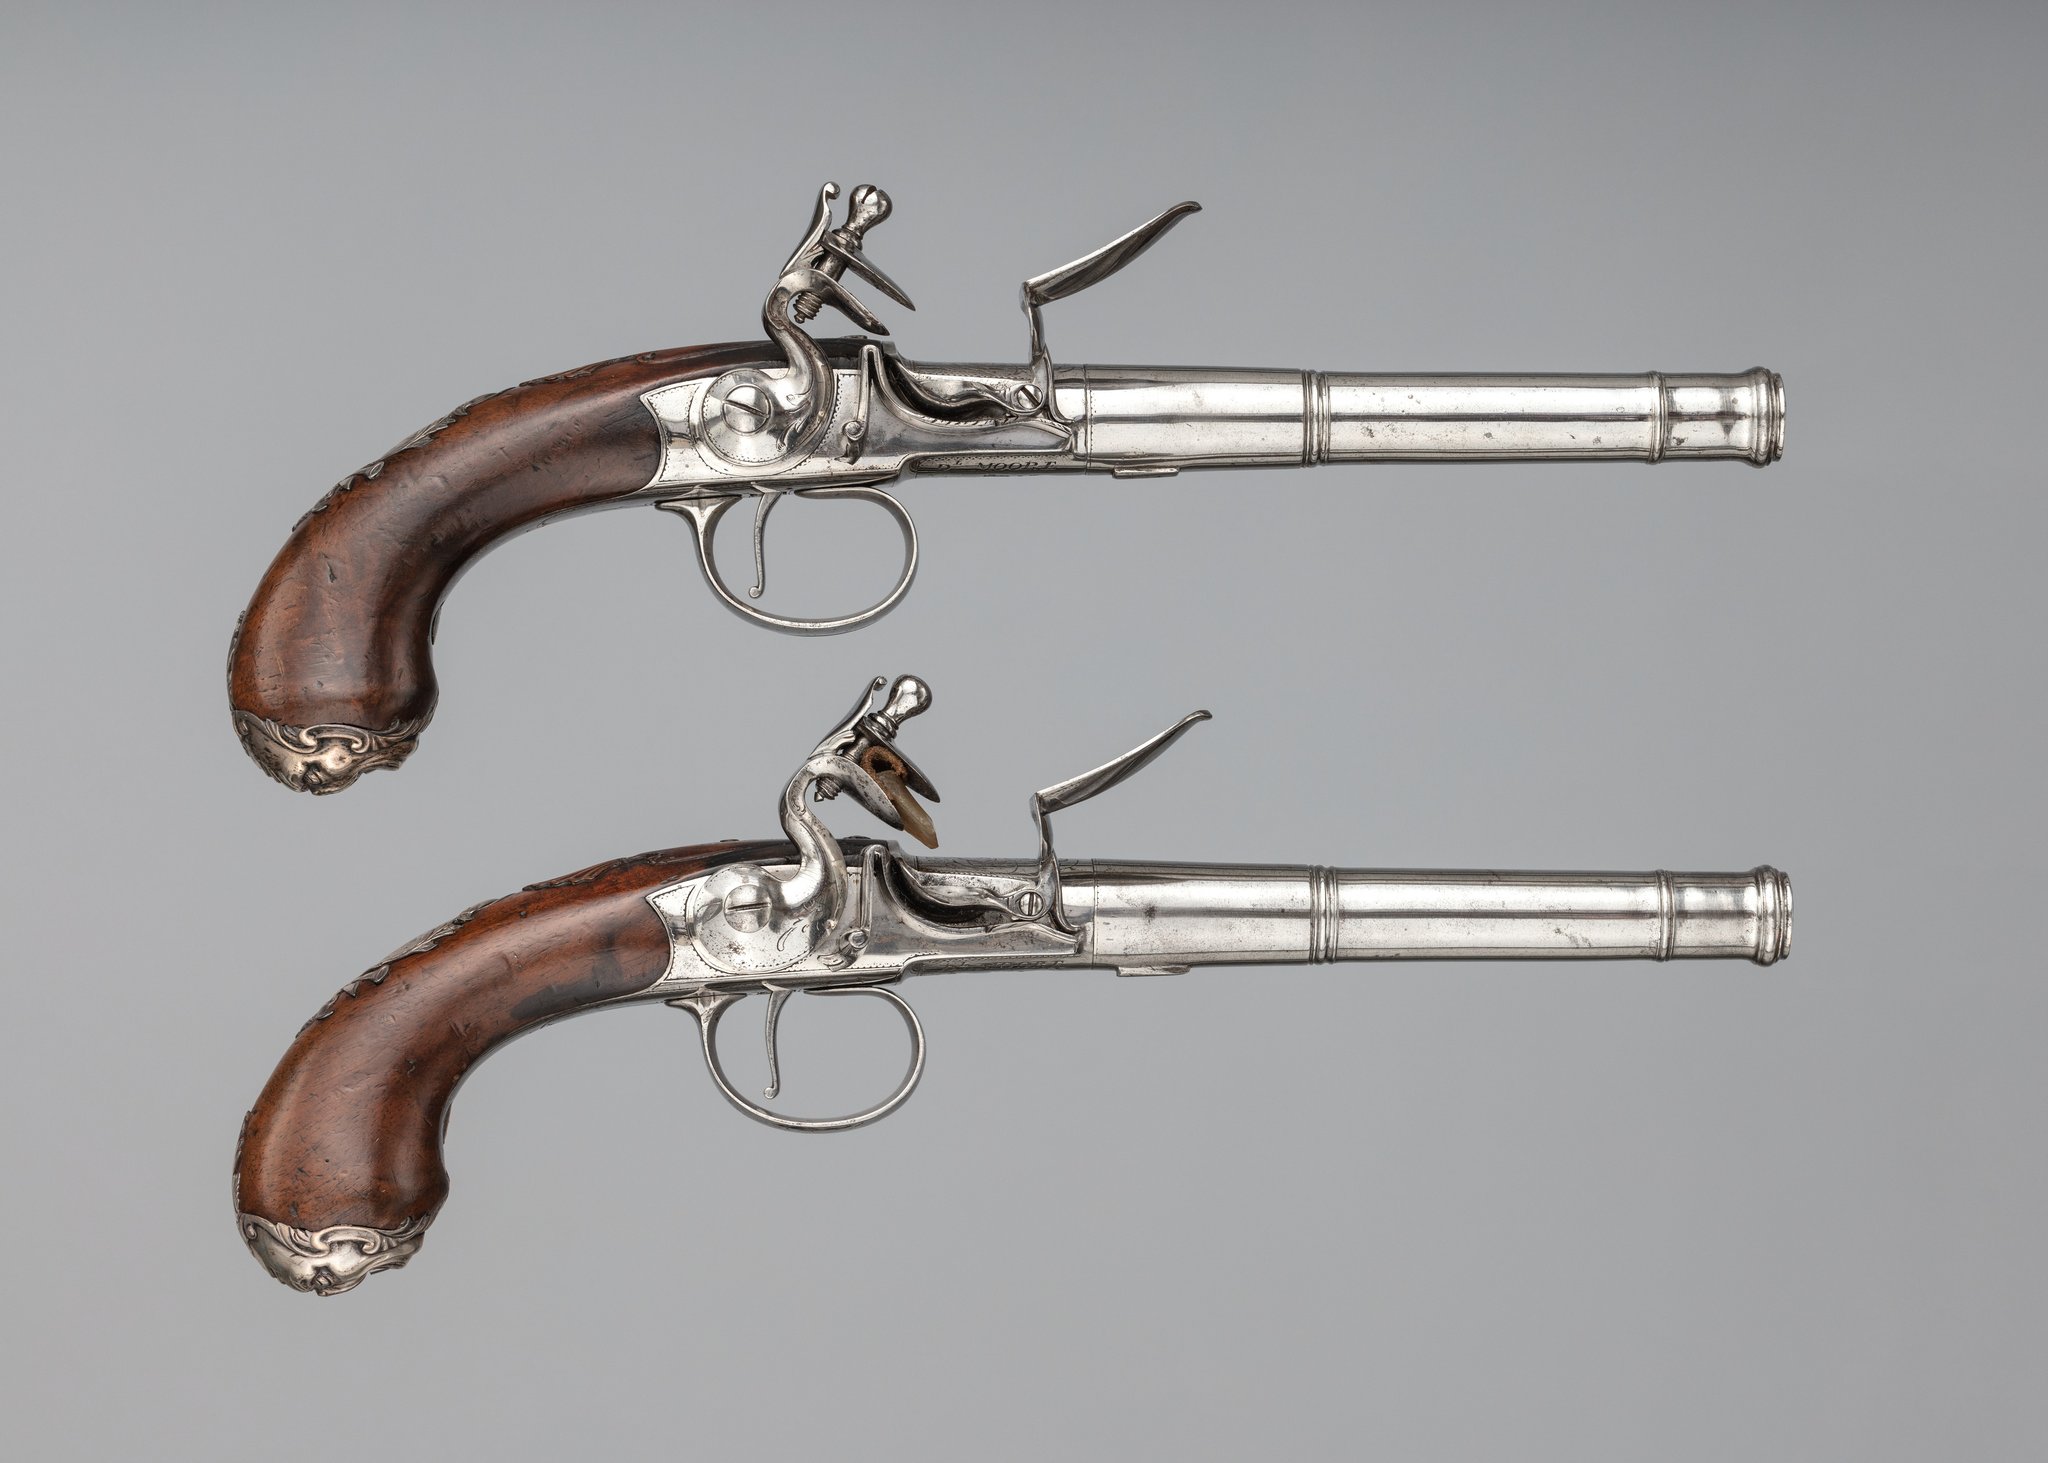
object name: pair of flintlock pistol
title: Pair of Flintlock Turn-Off Pistols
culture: british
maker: daniel moore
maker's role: gunsmith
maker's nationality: british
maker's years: 1758-1800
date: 1760-1780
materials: silver, steel, wood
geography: england